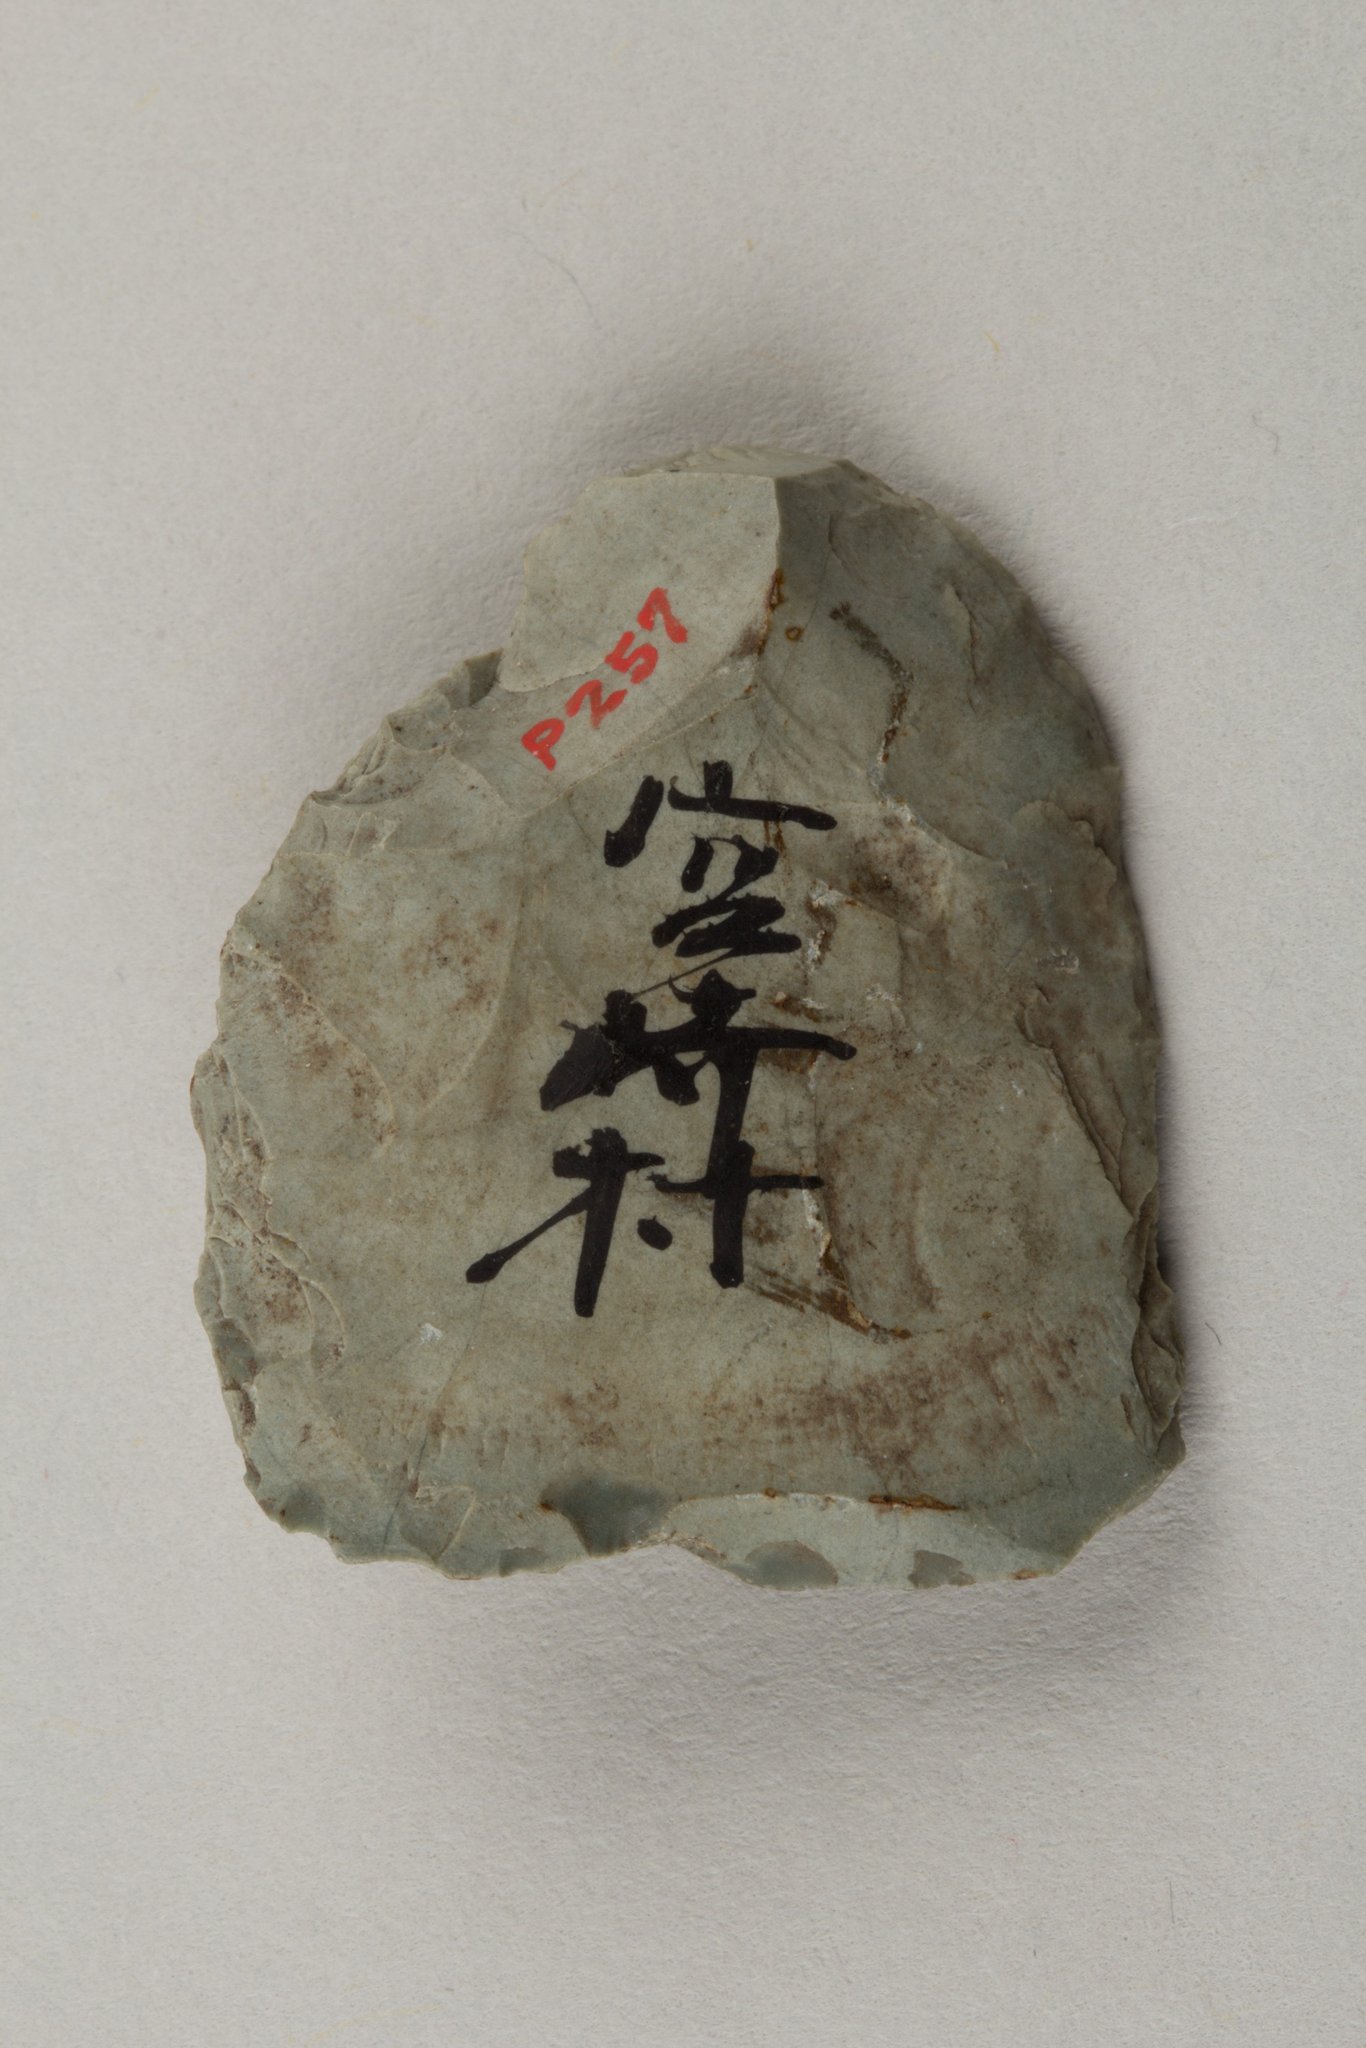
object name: arrowhead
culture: japanese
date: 1500-1000 BCE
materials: stone